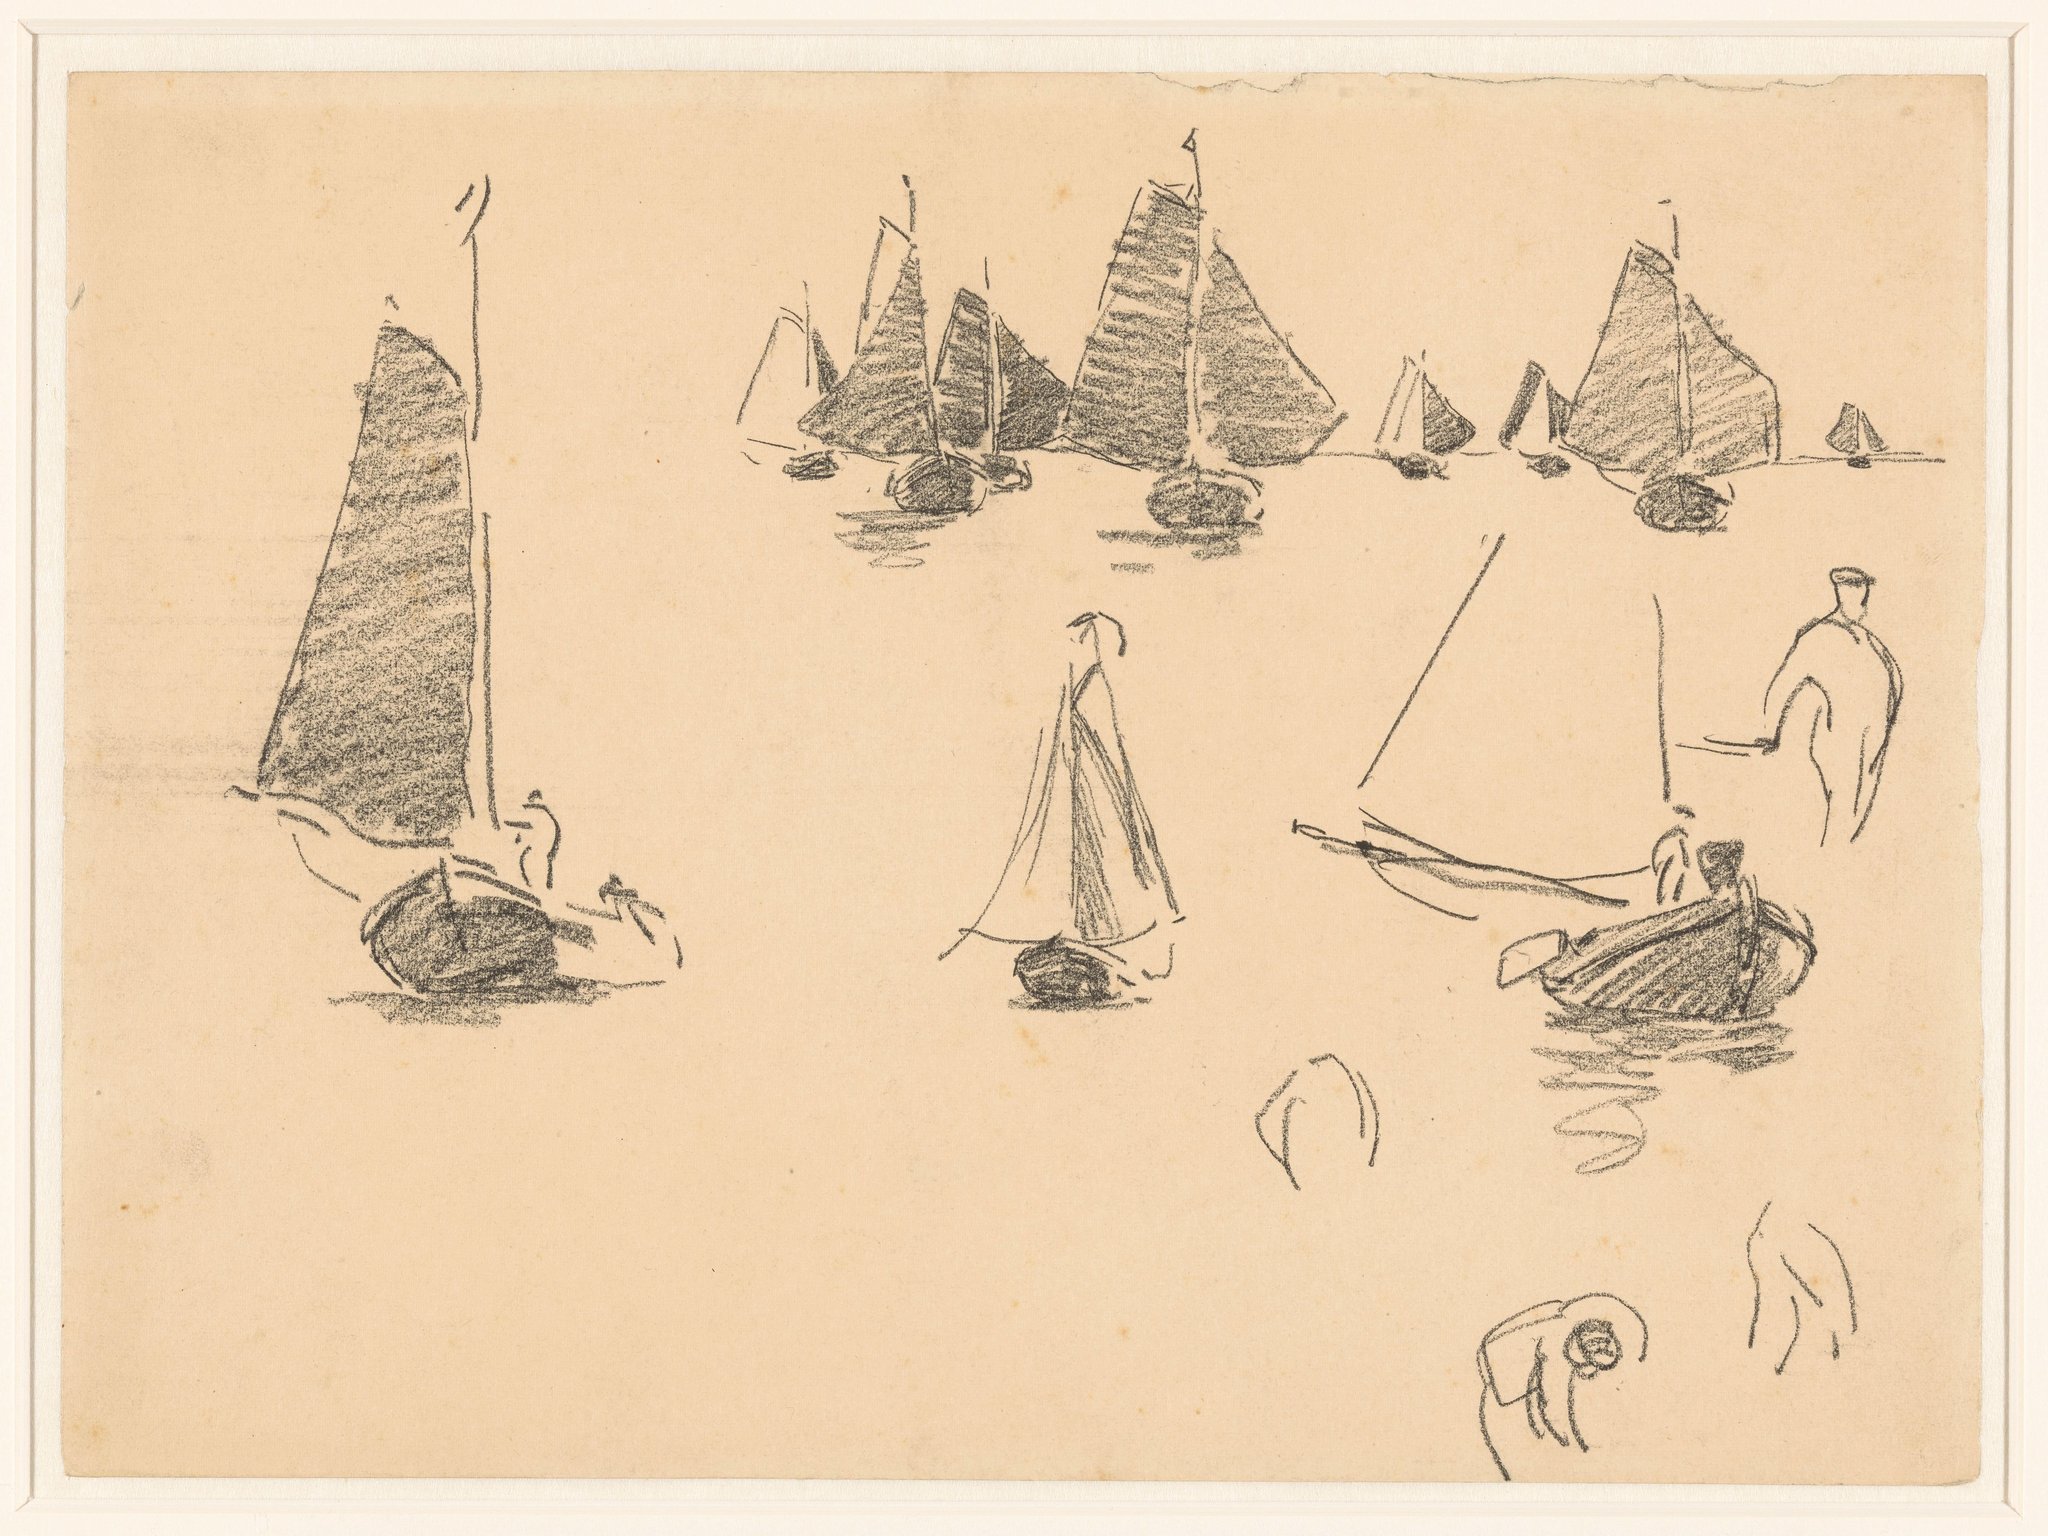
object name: drawing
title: Diverse studies van boten en enkele figuurstudies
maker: willem bastiaan tholen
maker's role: draughtsman, painter, print maker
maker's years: 1860-1931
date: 1870-1931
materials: chalk, paper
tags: ships (in general) - cc - more than one ship